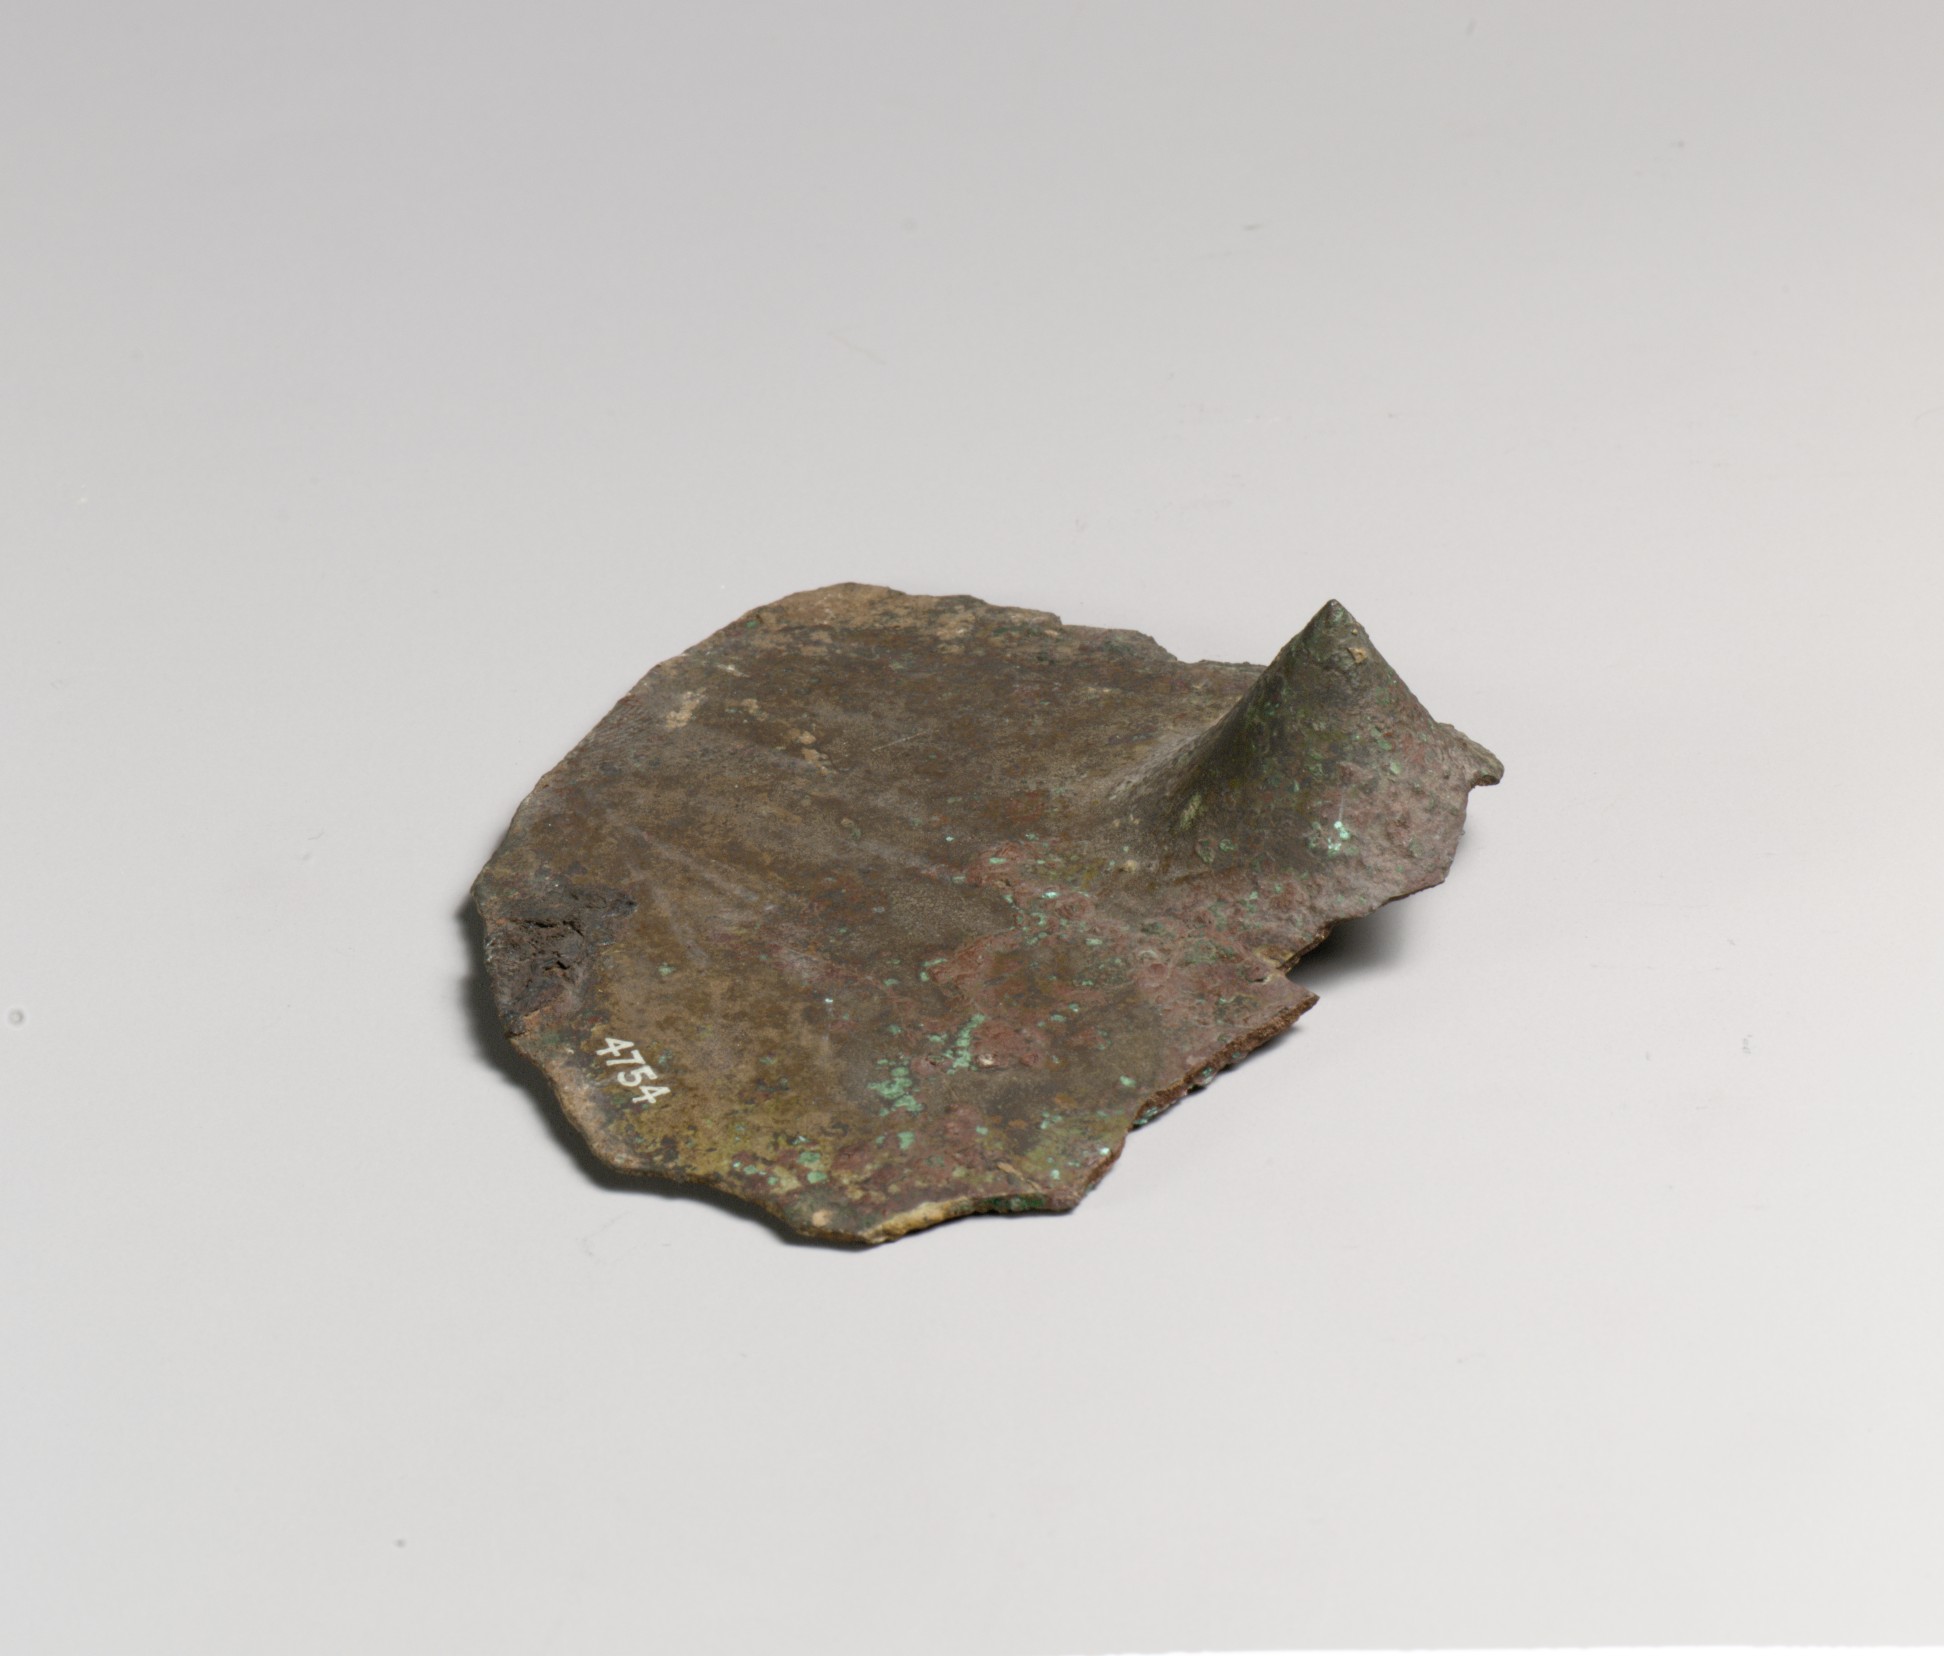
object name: shield bos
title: Shield boss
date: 7000 BCE-330 CE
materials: bronze